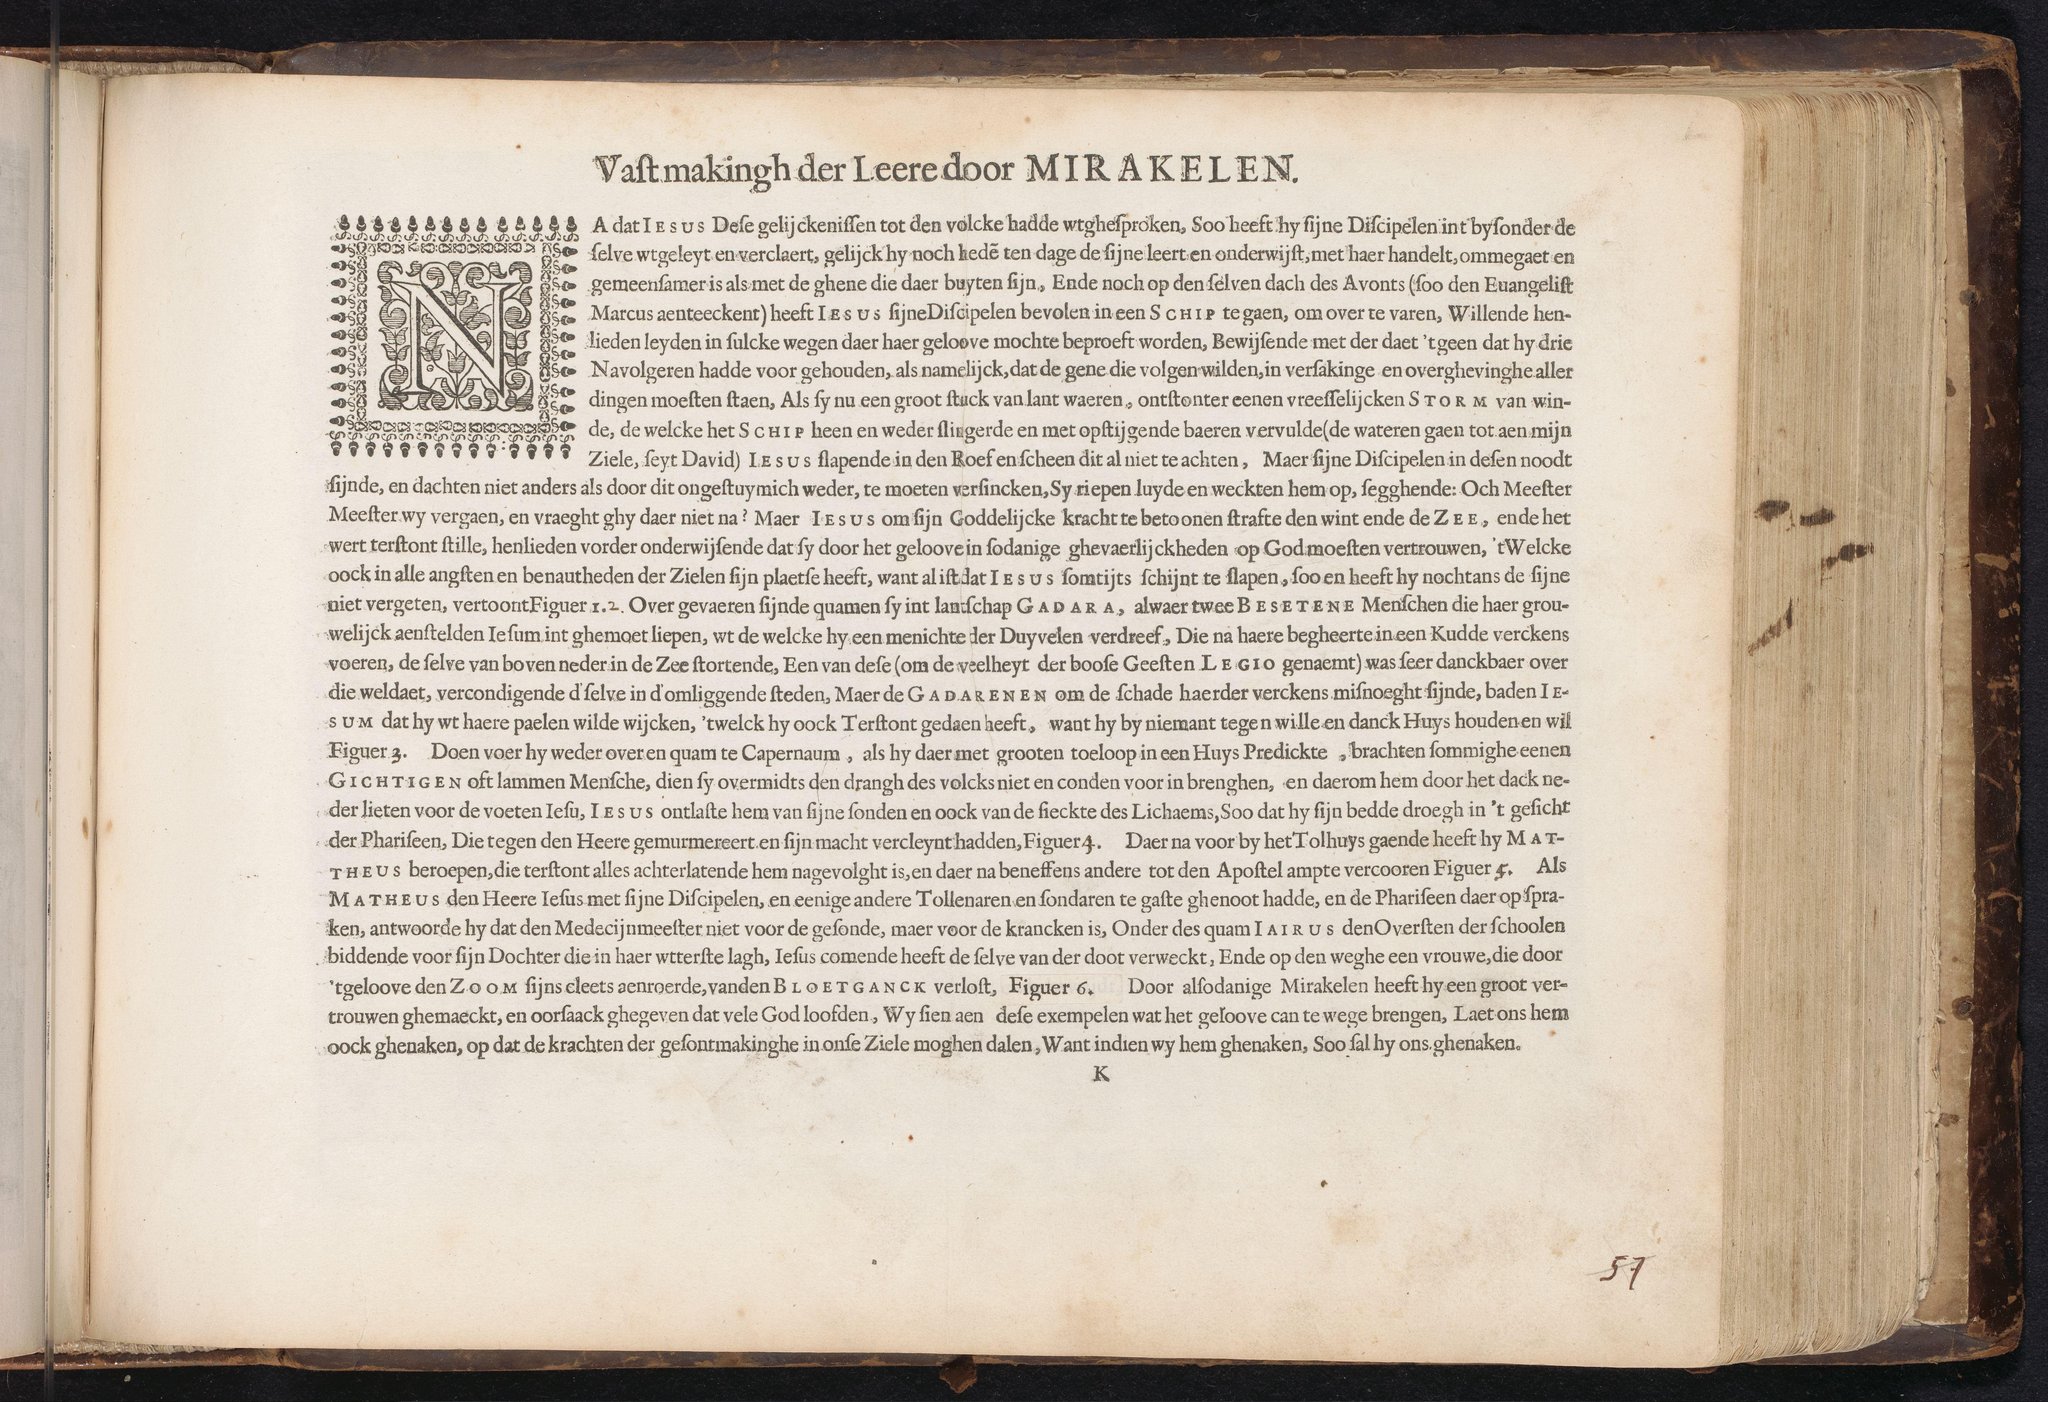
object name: text sheet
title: Den Grooten Figuer-Bibel (...)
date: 1646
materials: paper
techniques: letterpress printing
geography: alkmaar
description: Tekstblad bij een serie prenten over de wonderen van Christus. Linksboven initiaal N. Dit blad maakt deel uit van een album.